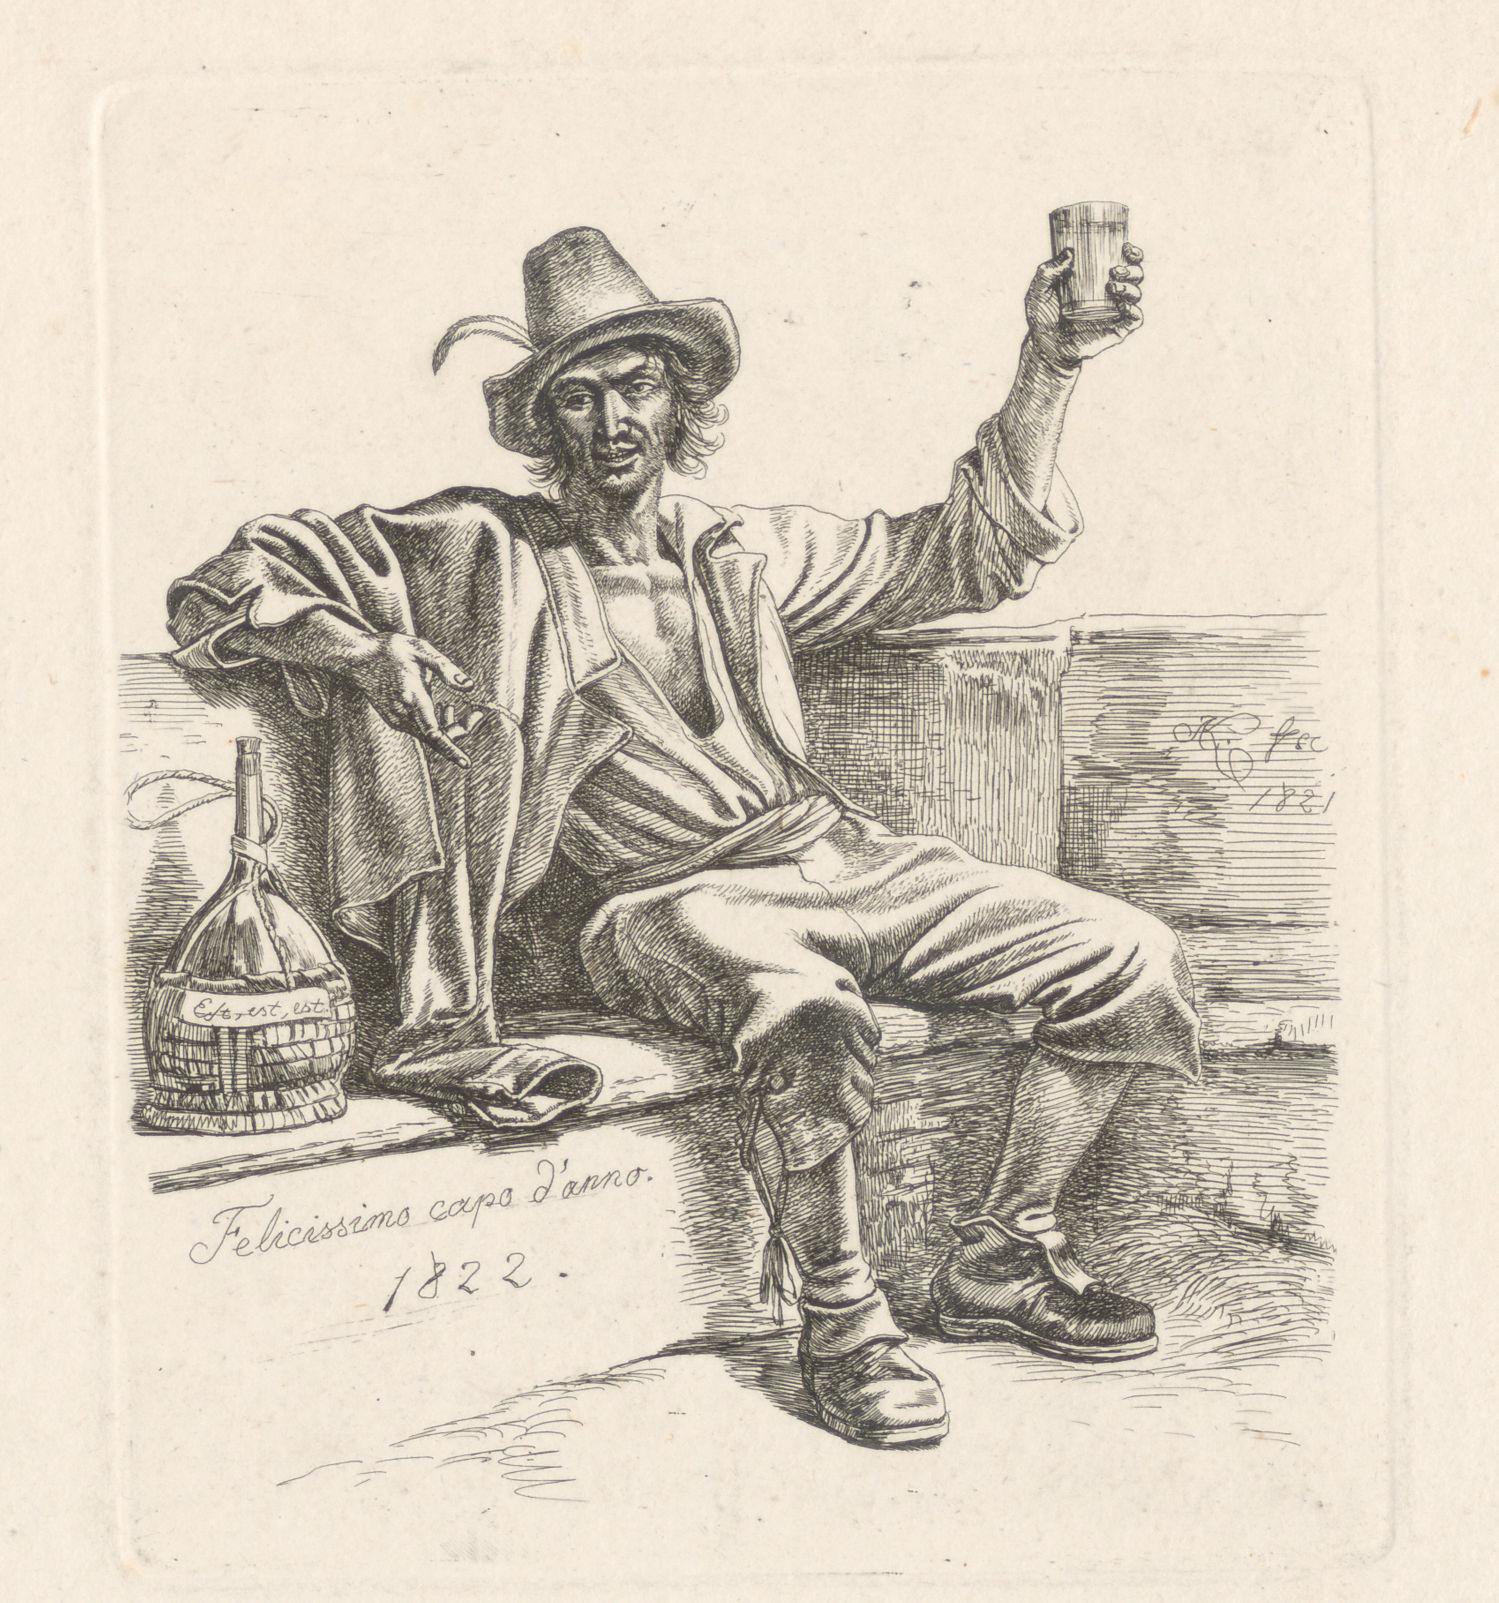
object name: print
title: Man op een bank heft zijn glas met wijn op het nieuwe jaar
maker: johann adam klein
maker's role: draughtsman, print maker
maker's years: 1792-1875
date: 1821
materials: paper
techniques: etching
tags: new year's eve (december 31), bottle of wine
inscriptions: collector's mark: Lugt 2228